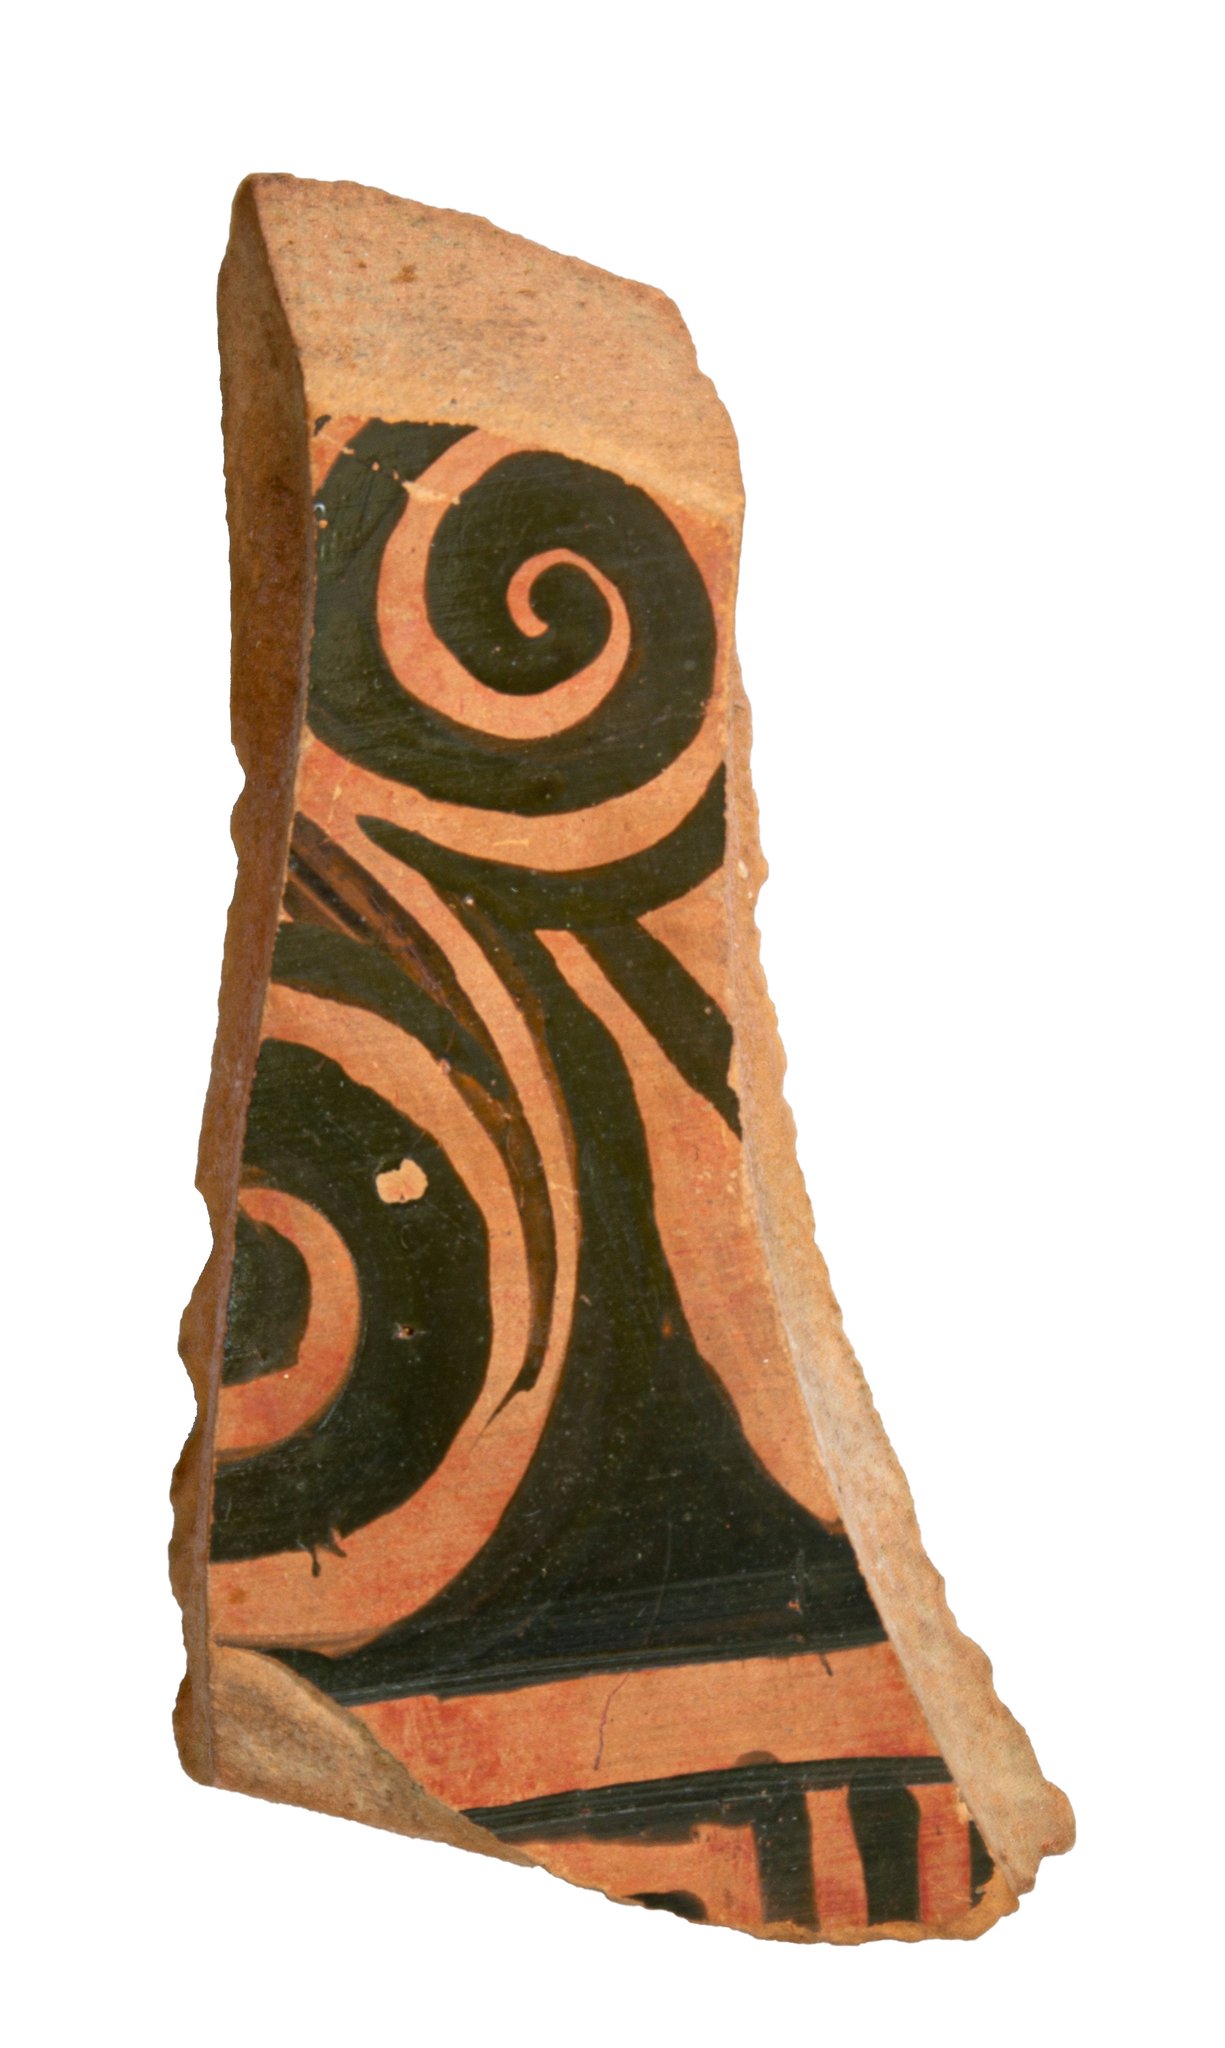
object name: volute krater fragment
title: Volute-krater fragment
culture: greek, south italian, apulian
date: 400-301 BCE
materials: terracotta